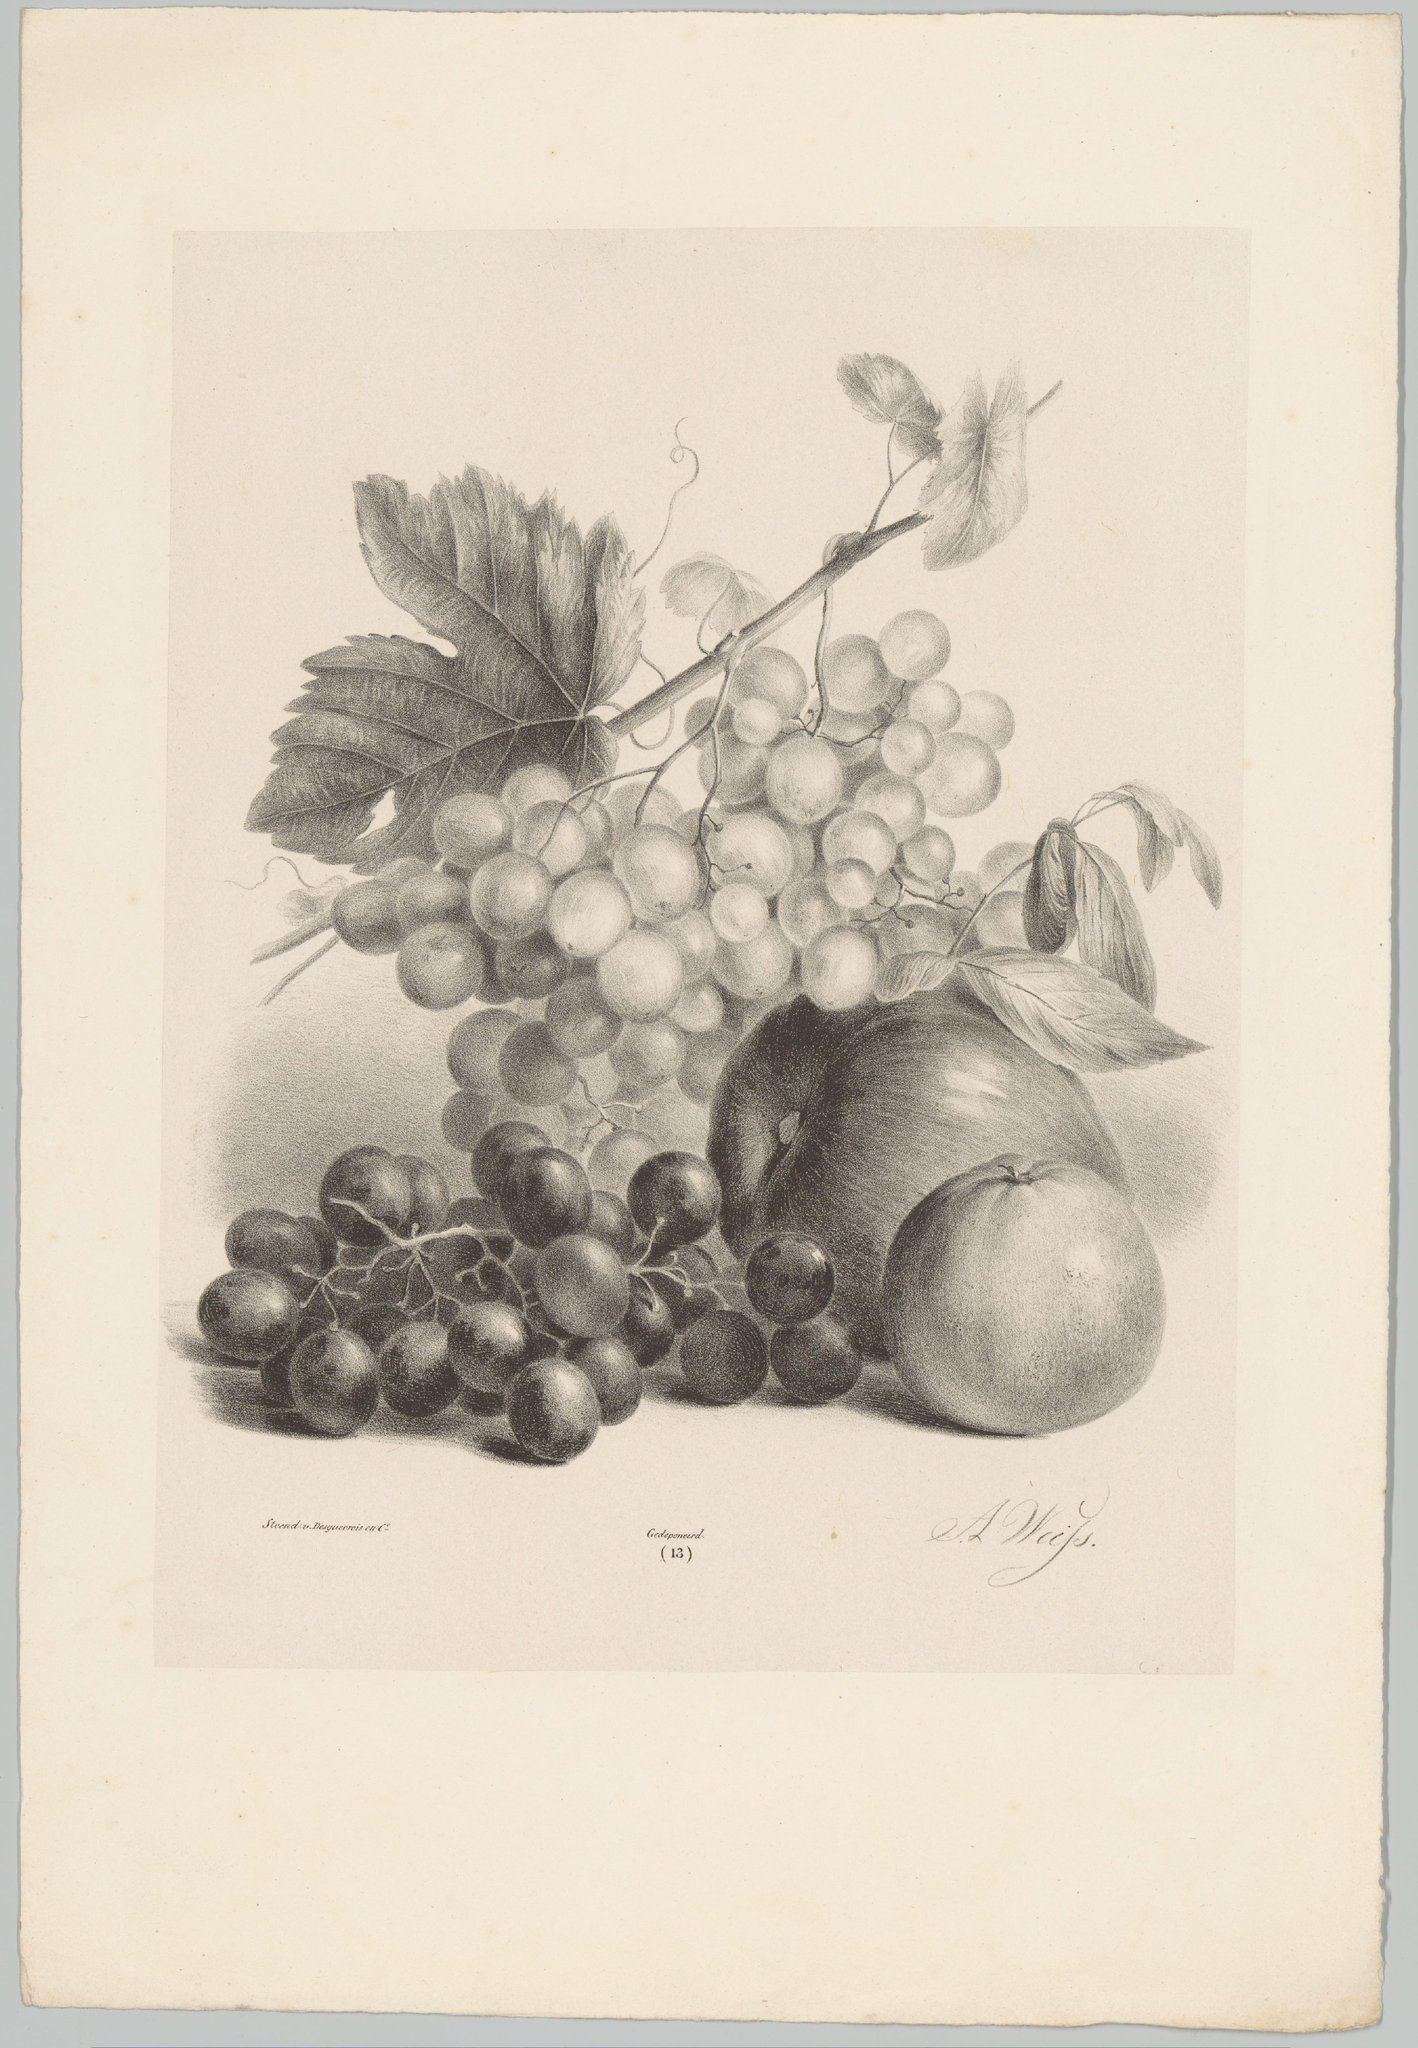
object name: print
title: Rode en witte druiven en appels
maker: anton weiss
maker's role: draughtsman, print maker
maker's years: 1801-1851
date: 1836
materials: paper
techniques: lithograph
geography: amsterdam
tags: fruits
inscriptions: : ‘Gedeponeerd.’, collector's mark: Lugt 2228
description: Onderdeel van een omslag met een serie van eenenveertig lithografieën van bloemen en fruit.